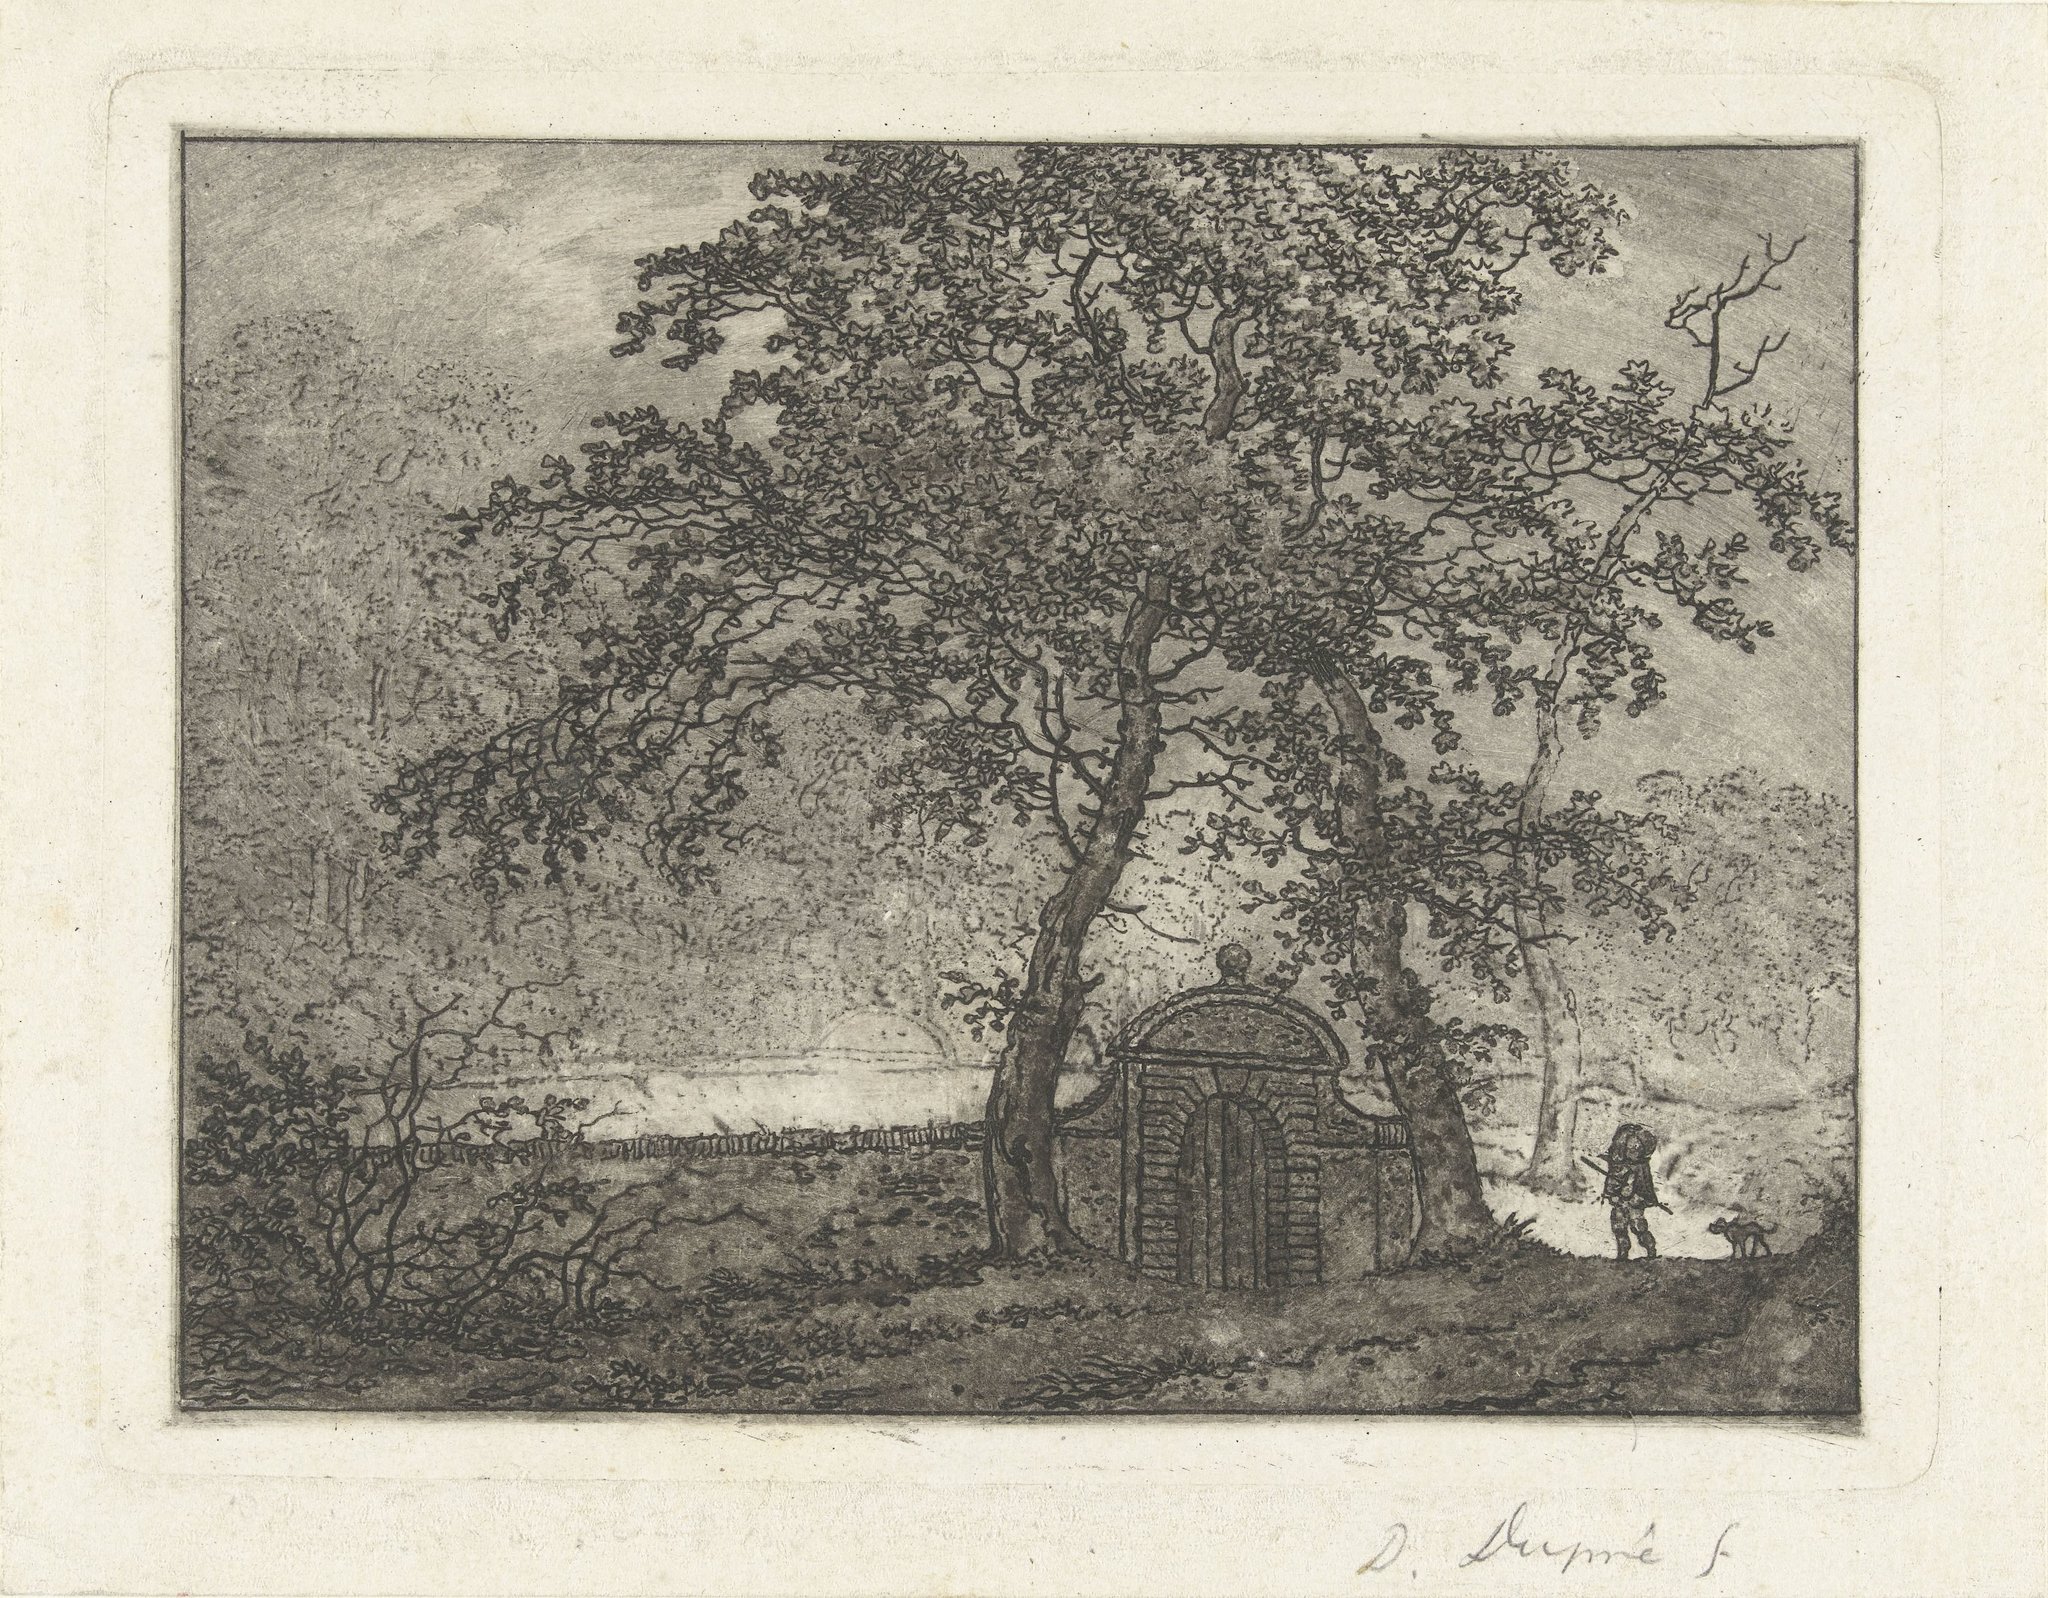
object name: print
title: Man met hond bij de poort van een begraafplaats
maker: daniël dupré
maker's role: draughtsman, print maker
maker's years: 1751-1817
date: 1771-1817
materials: paper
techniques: aquatint, etching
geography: netherlands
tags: cemetery, park-like burying ground, dog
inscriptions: collector's mark: Lugt 2228